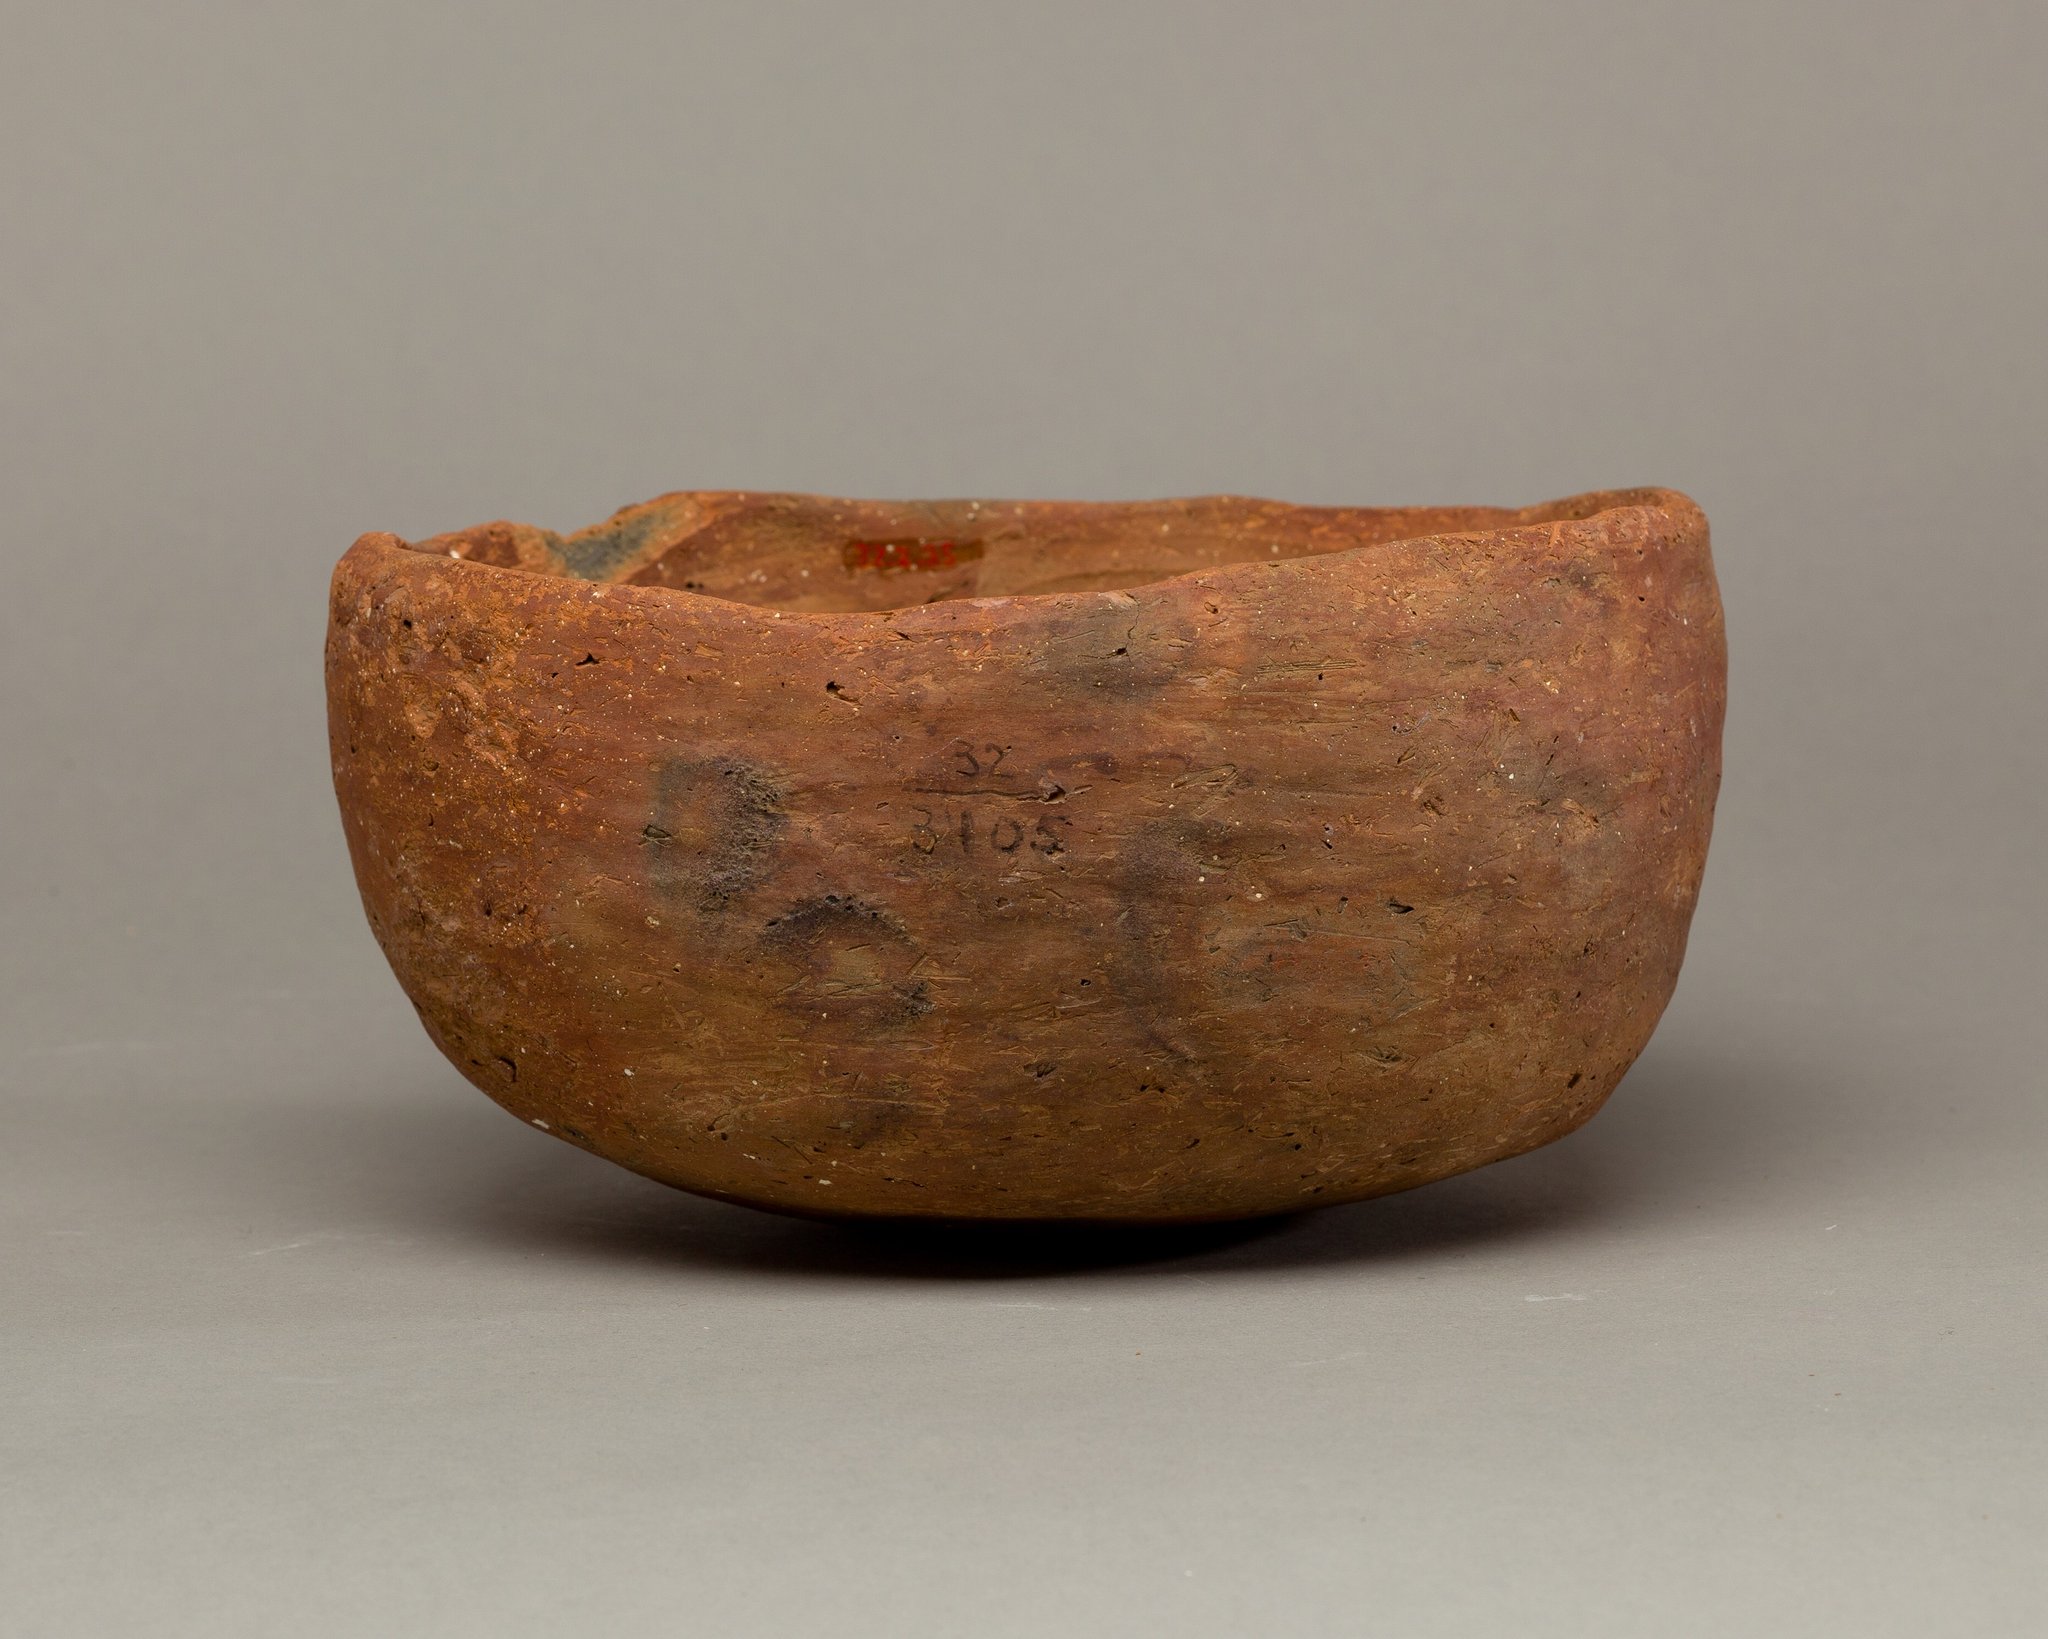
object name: bowl, rough red pottery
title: Bowl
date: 4500-4000 BCE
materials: pottery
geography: egypt